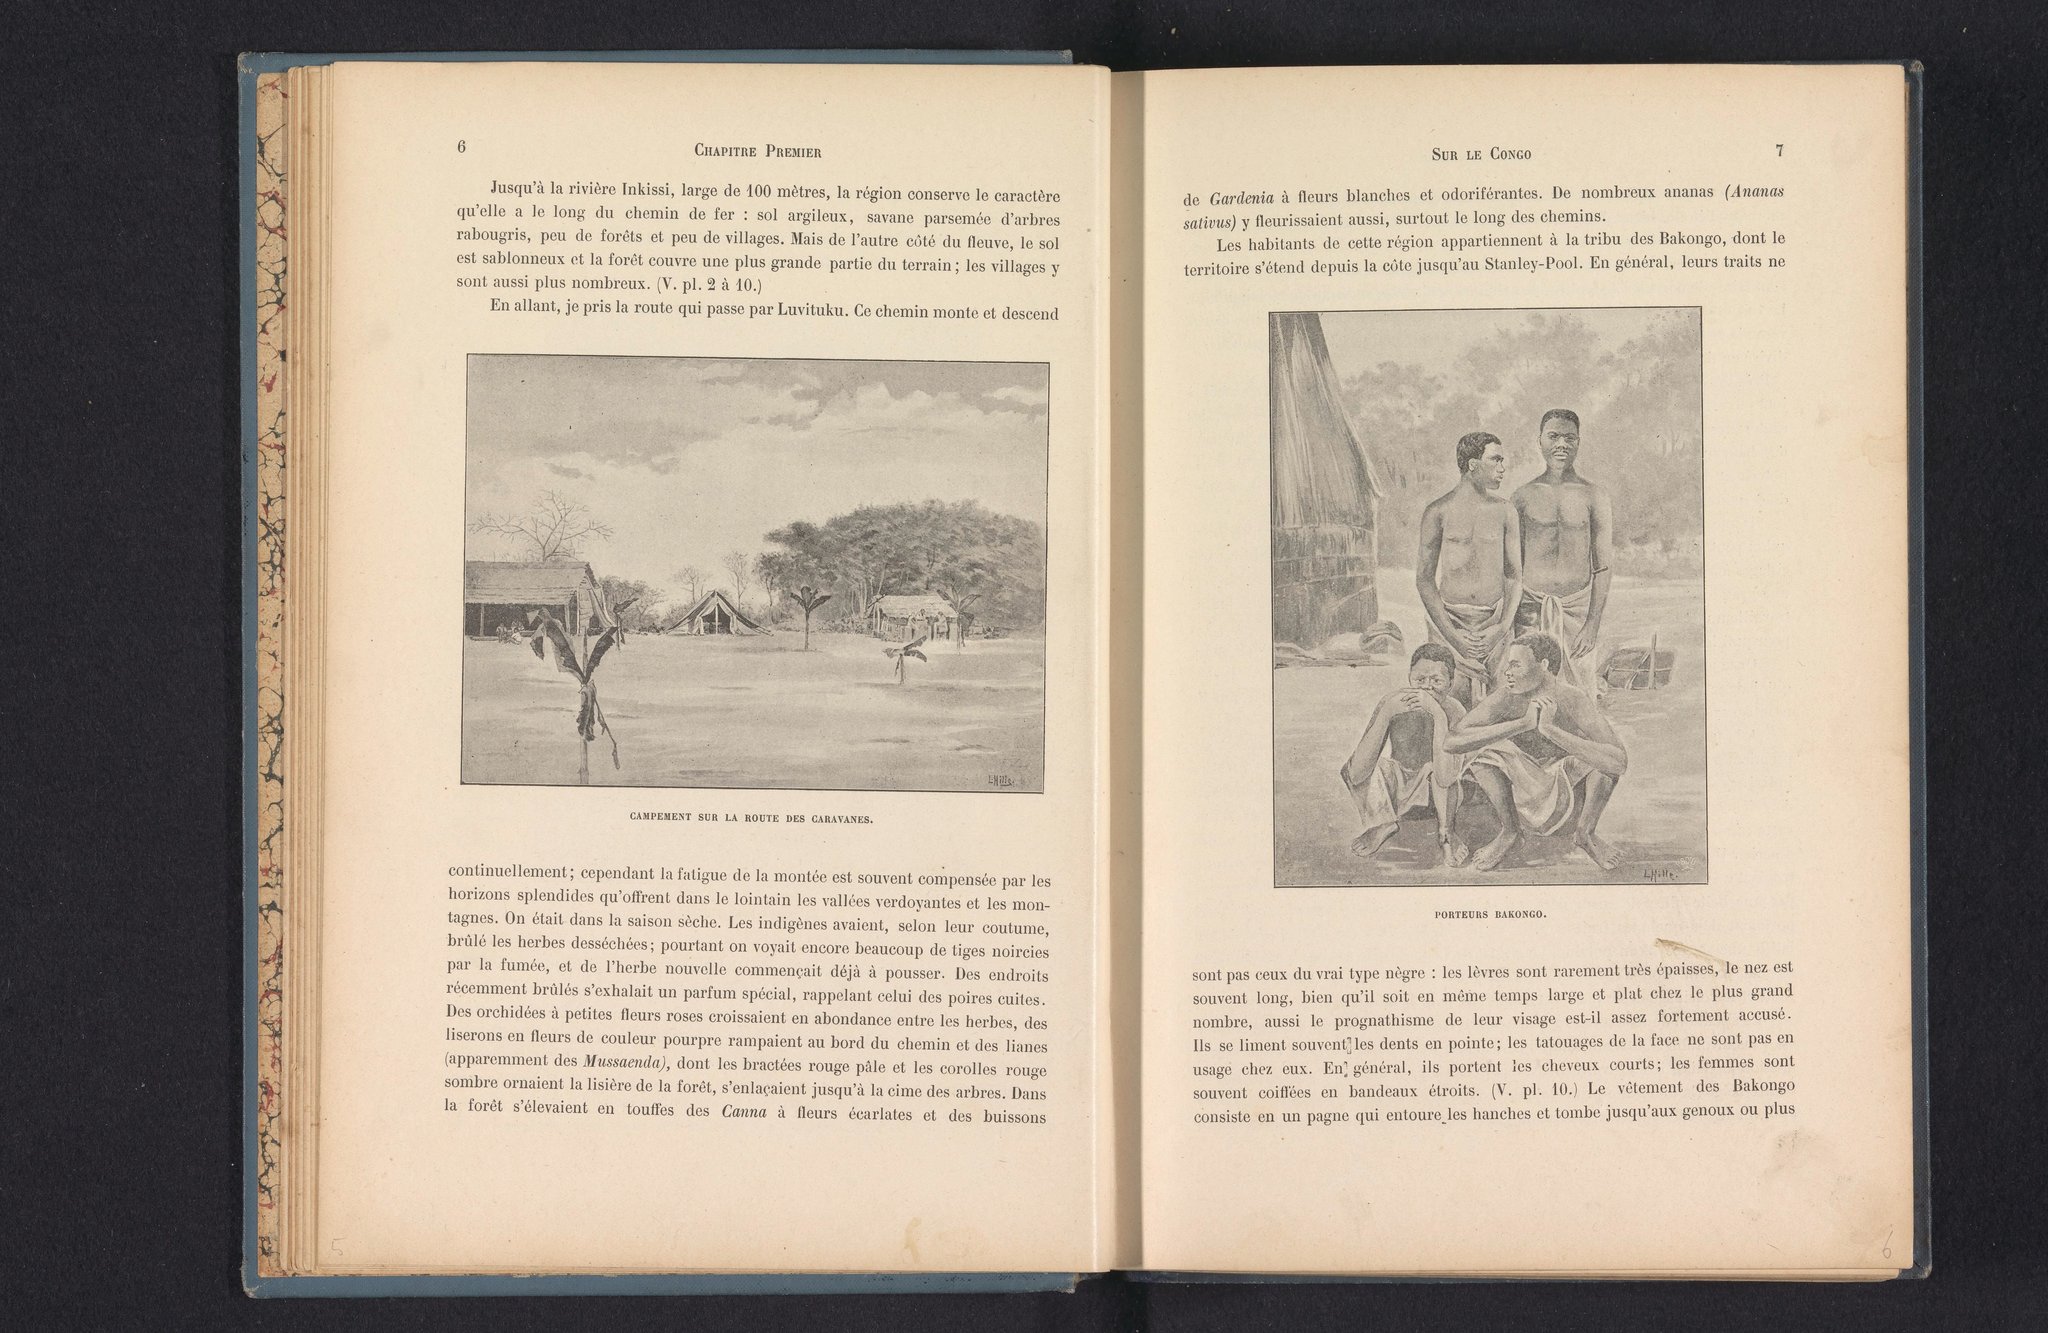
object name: reproduction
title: Porteurs Bakongo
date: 1896-1899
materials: paper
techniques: autotype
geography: dresden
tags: porter, bearer